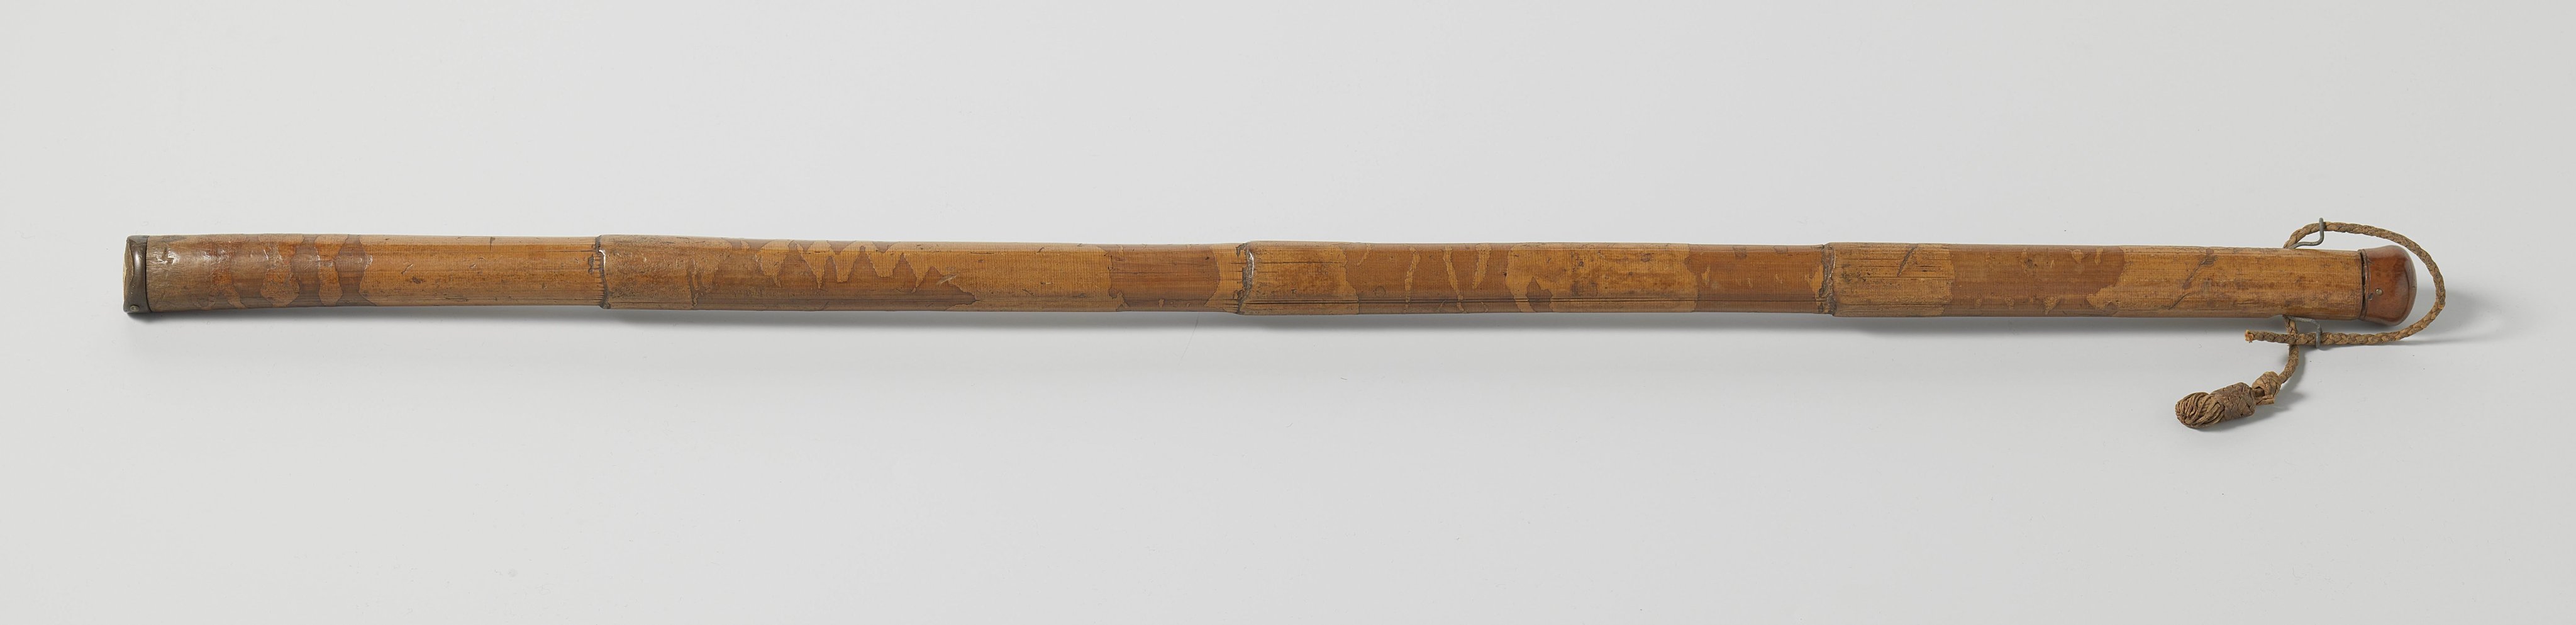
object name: rotting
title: Rotting van Piet Hein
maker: Anonymous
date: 1600-1650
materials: bamboo, leather, metal, paper, wood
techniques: braiding, cutting, forging, turning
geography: netherlands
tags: delfshaven, netherlands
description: Eenvoudige bamboestok met kleine, ronde houten knop waaronder een gevlochten leren koordje door een gat dwars door de stok heenloopt en wordt vastgehouden door een stuk metaaldraad. Het koordje vormde oorspronkelijk een lus door de uiteinden samen te laten komen bij een kwastje, waar één uiteinde nu gebroken is. De punt van de stik is plat en omgeven door een afgesleten metalen ring. Gemerkt: Onderop een klein etiket: 57.